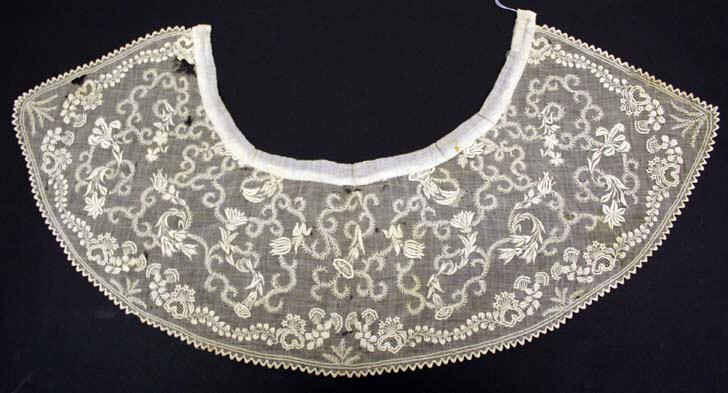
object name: collar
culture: french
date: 1800-1850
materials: cotton